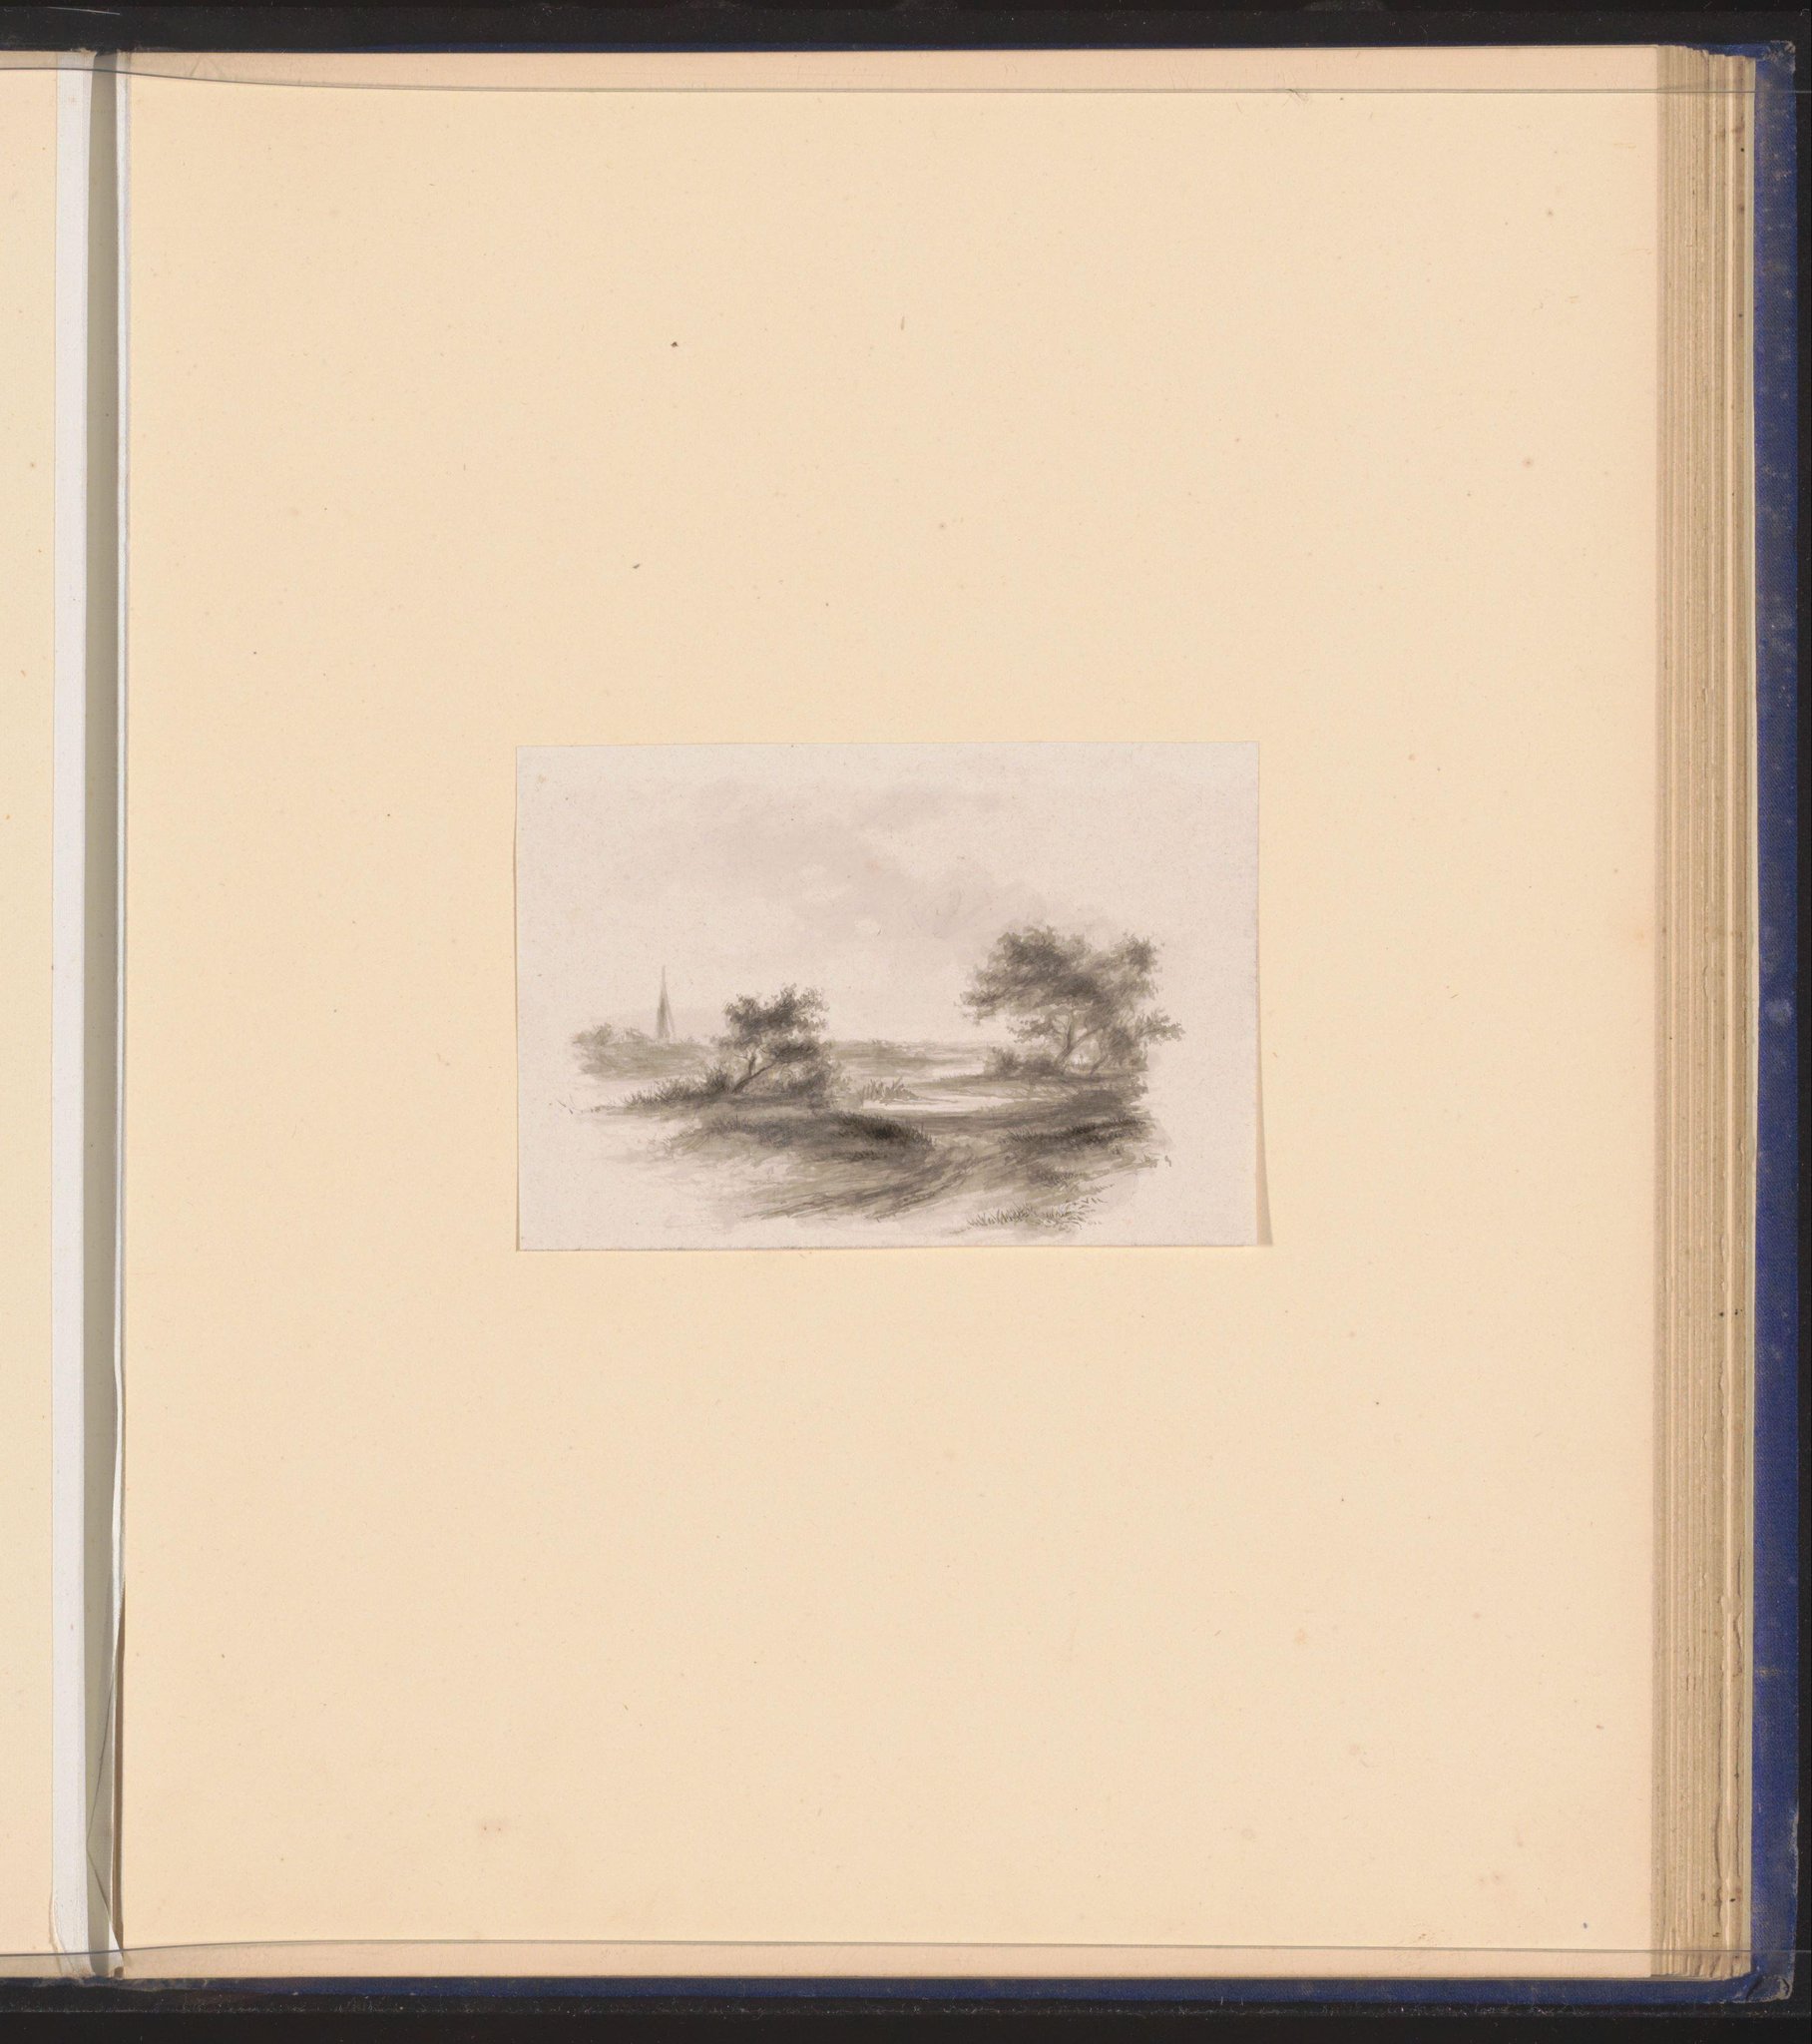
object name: drawing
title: Landschap met bomen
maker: alexander ver huell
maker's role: draughtsman, print maker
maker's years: 1822-1897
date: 1882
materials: ink, paper, watercolor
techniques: brush, pen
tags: trees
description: Op de achtergrond een zeil of torenspits. Tekening op blad 10 van een album met 24 ingeplakte schetsen.